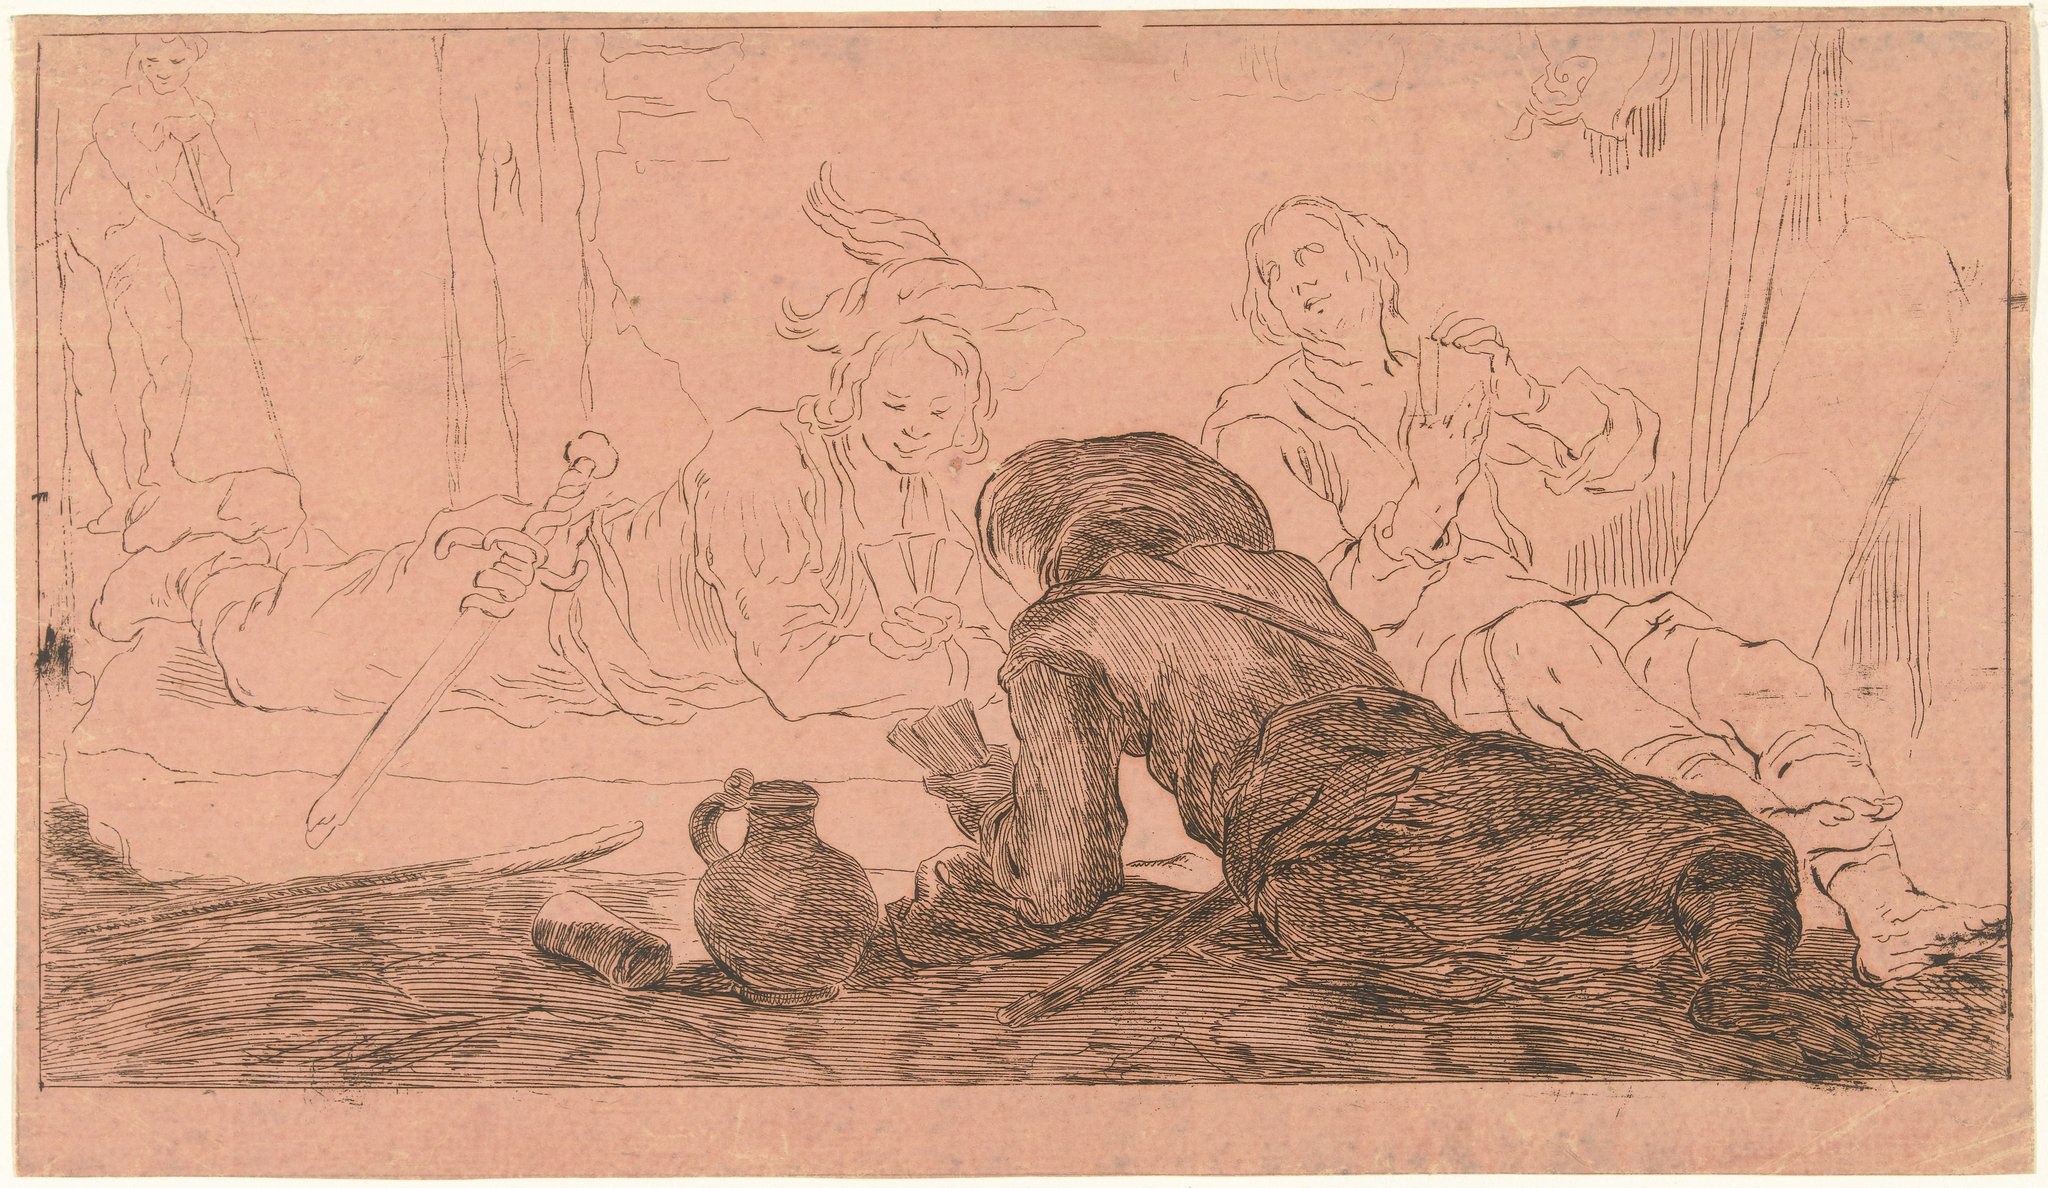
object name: print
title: Kaartspelers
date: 1767-1782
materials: paper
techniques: etching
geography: northern netherlands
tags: playing-cards, the soldier off duty, lying figure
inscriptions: collector's mark: Lugt 2228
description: Twee liggende en een zittende figuur spelen kaart.